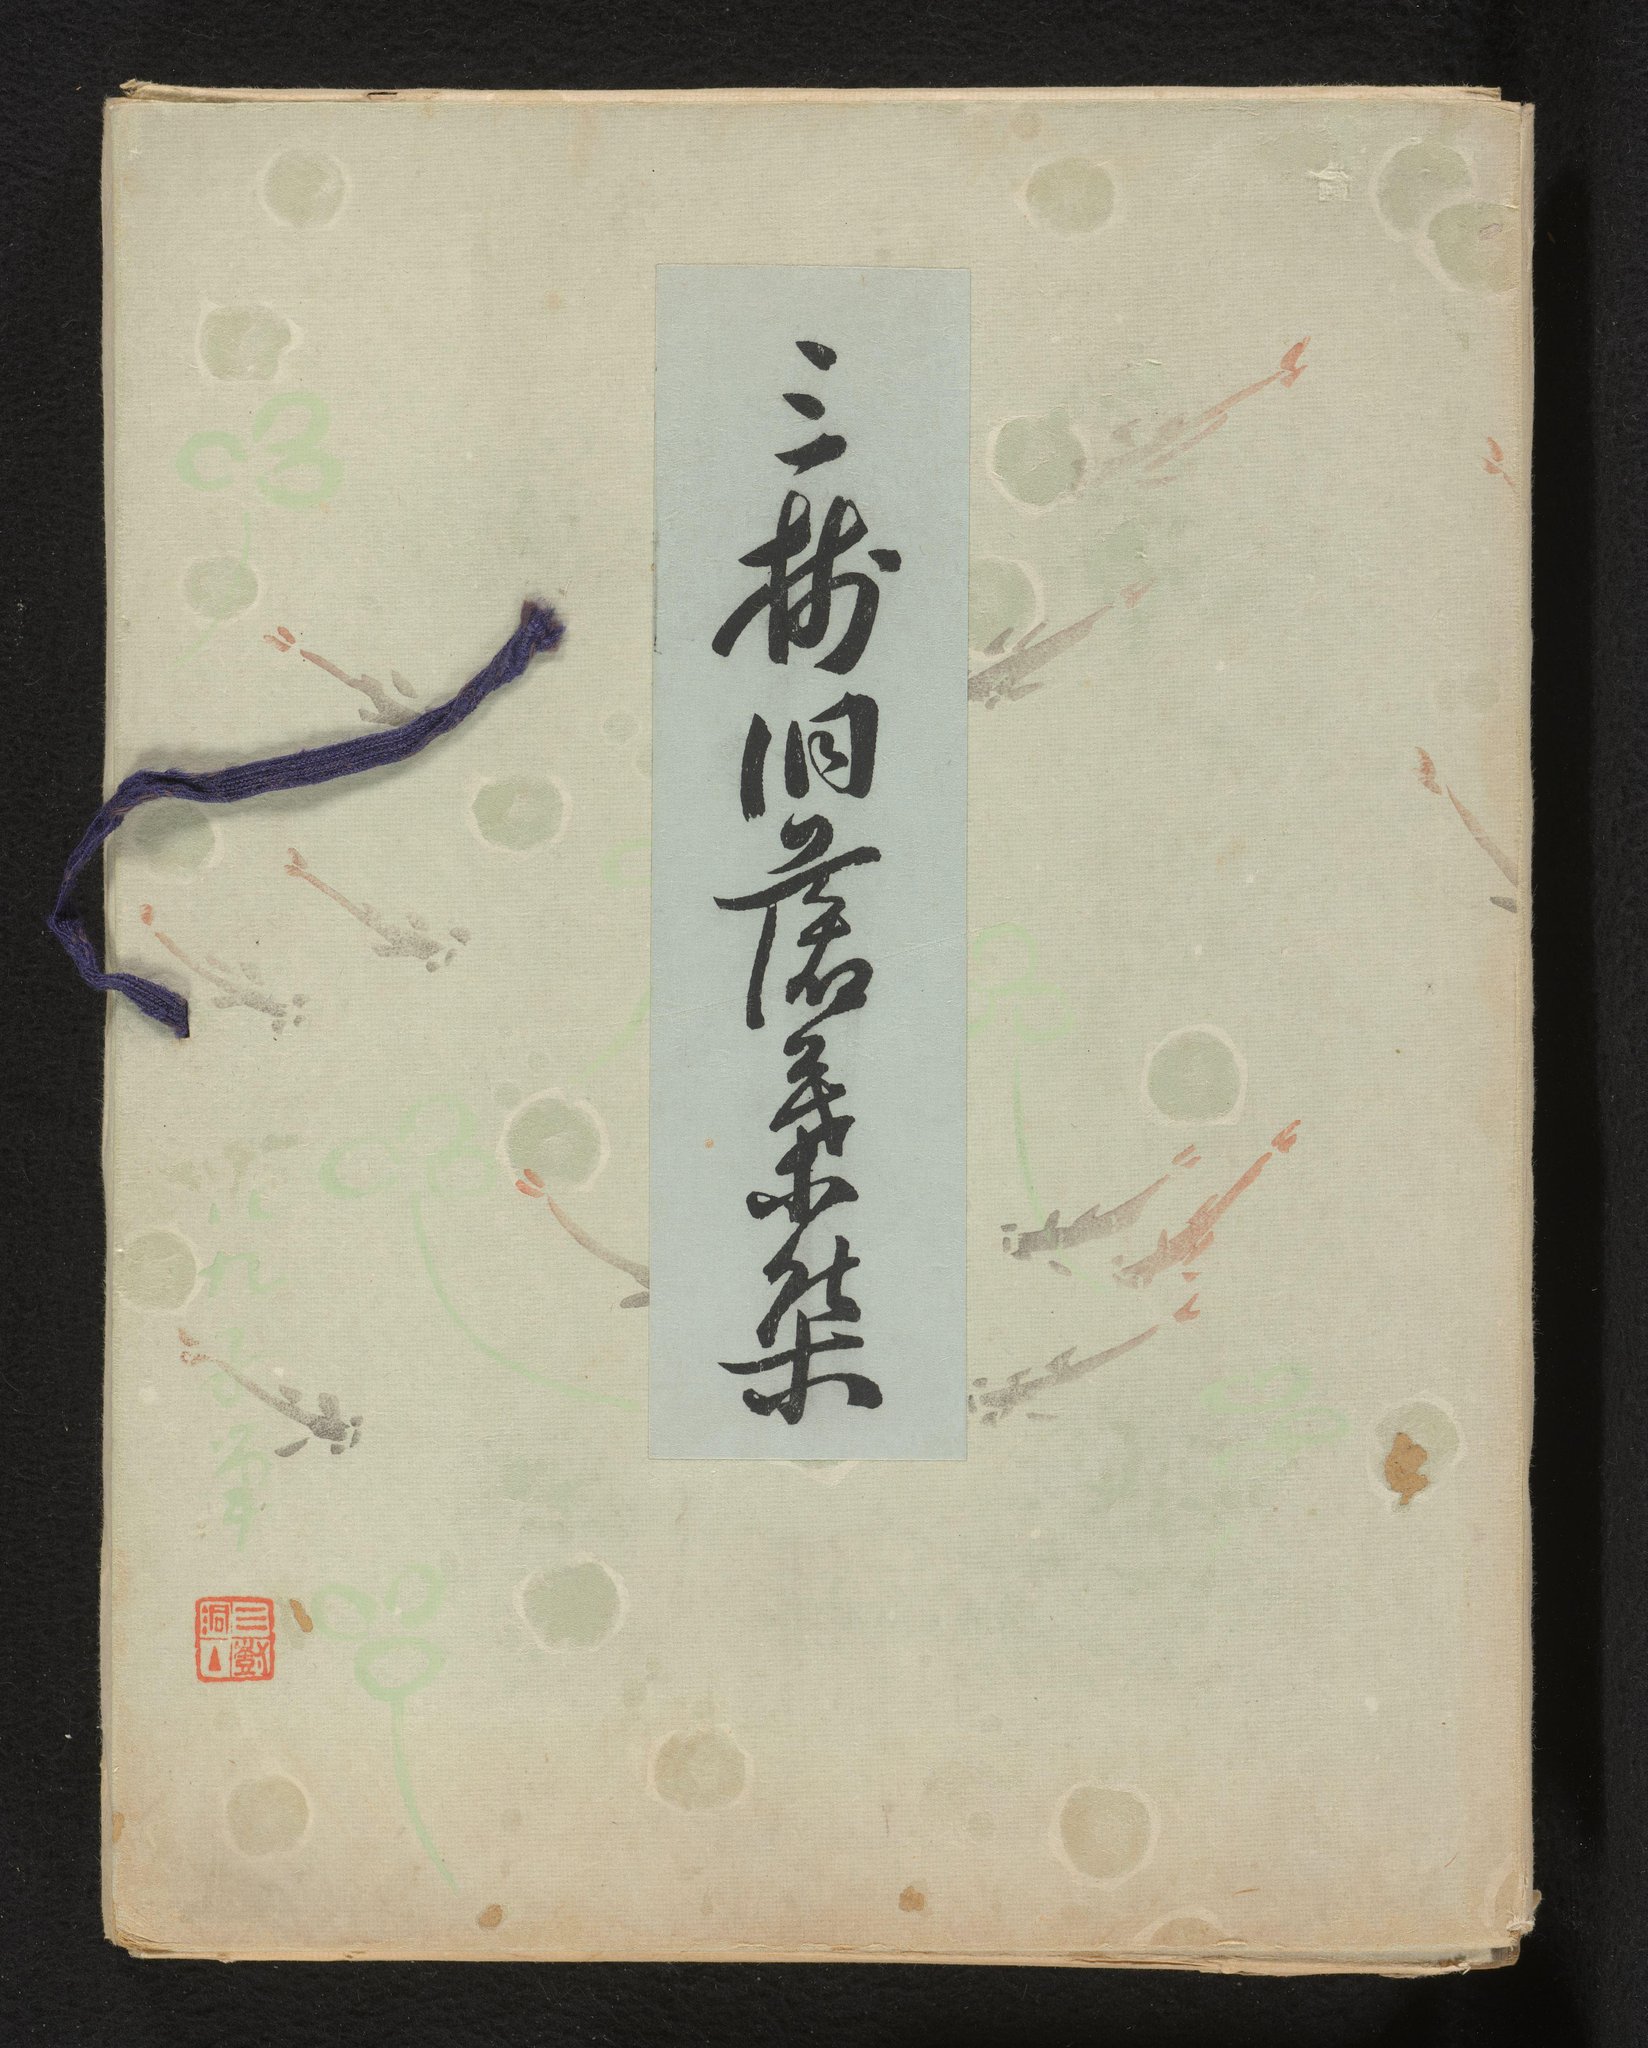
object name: book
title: Verzameling bladeren van Mikido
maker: yamaguchi hachikushi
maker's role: painter, print maker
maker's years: 1890-1933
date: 1934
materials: paper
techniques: woodcut, letterpress printing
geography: kyoto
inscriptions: date